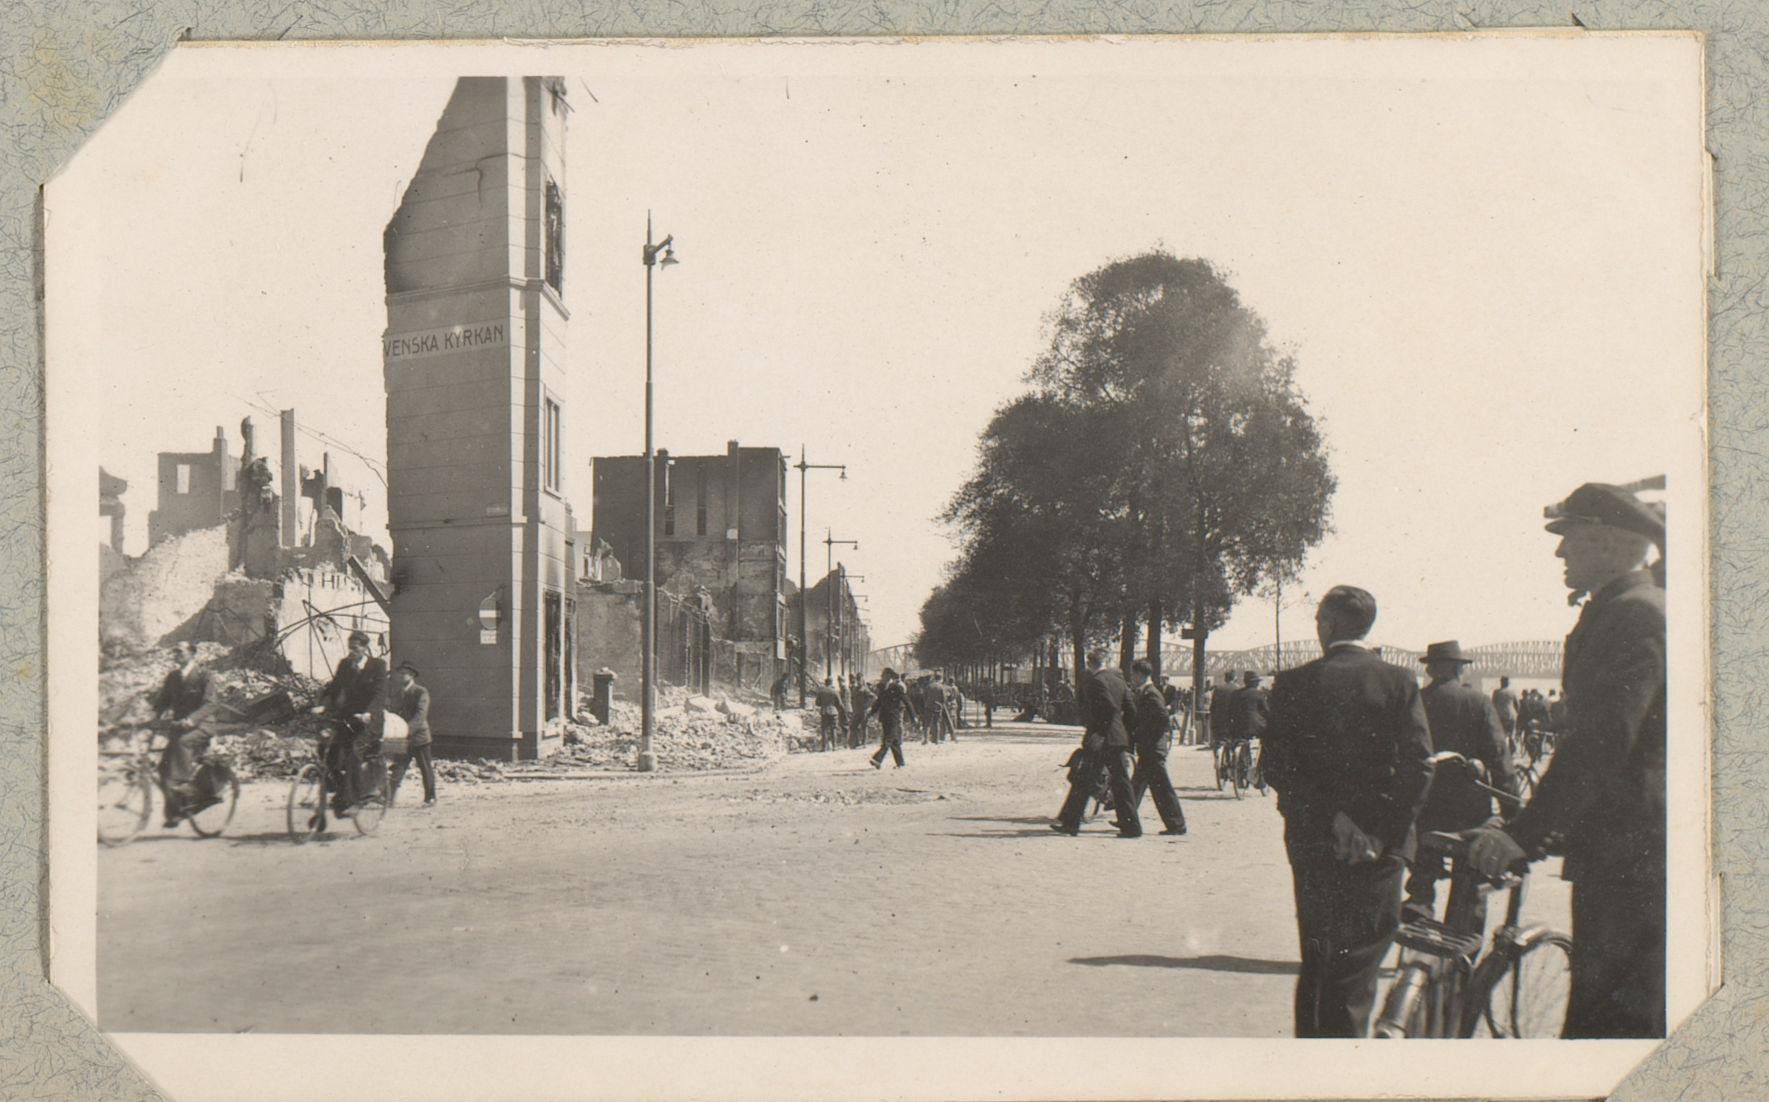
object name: photograph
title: Personen kijkend naar de ruïnes bij de Boompjes te Rotterdam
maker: j. nolte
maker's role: fotograaf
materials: photographic support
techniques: gelatin silver print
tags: historical persons, devastated, ruined place or city (~ warfare), street, ruin of a dwelling, house, castle, etc., rotterdam, rotterdam blitz